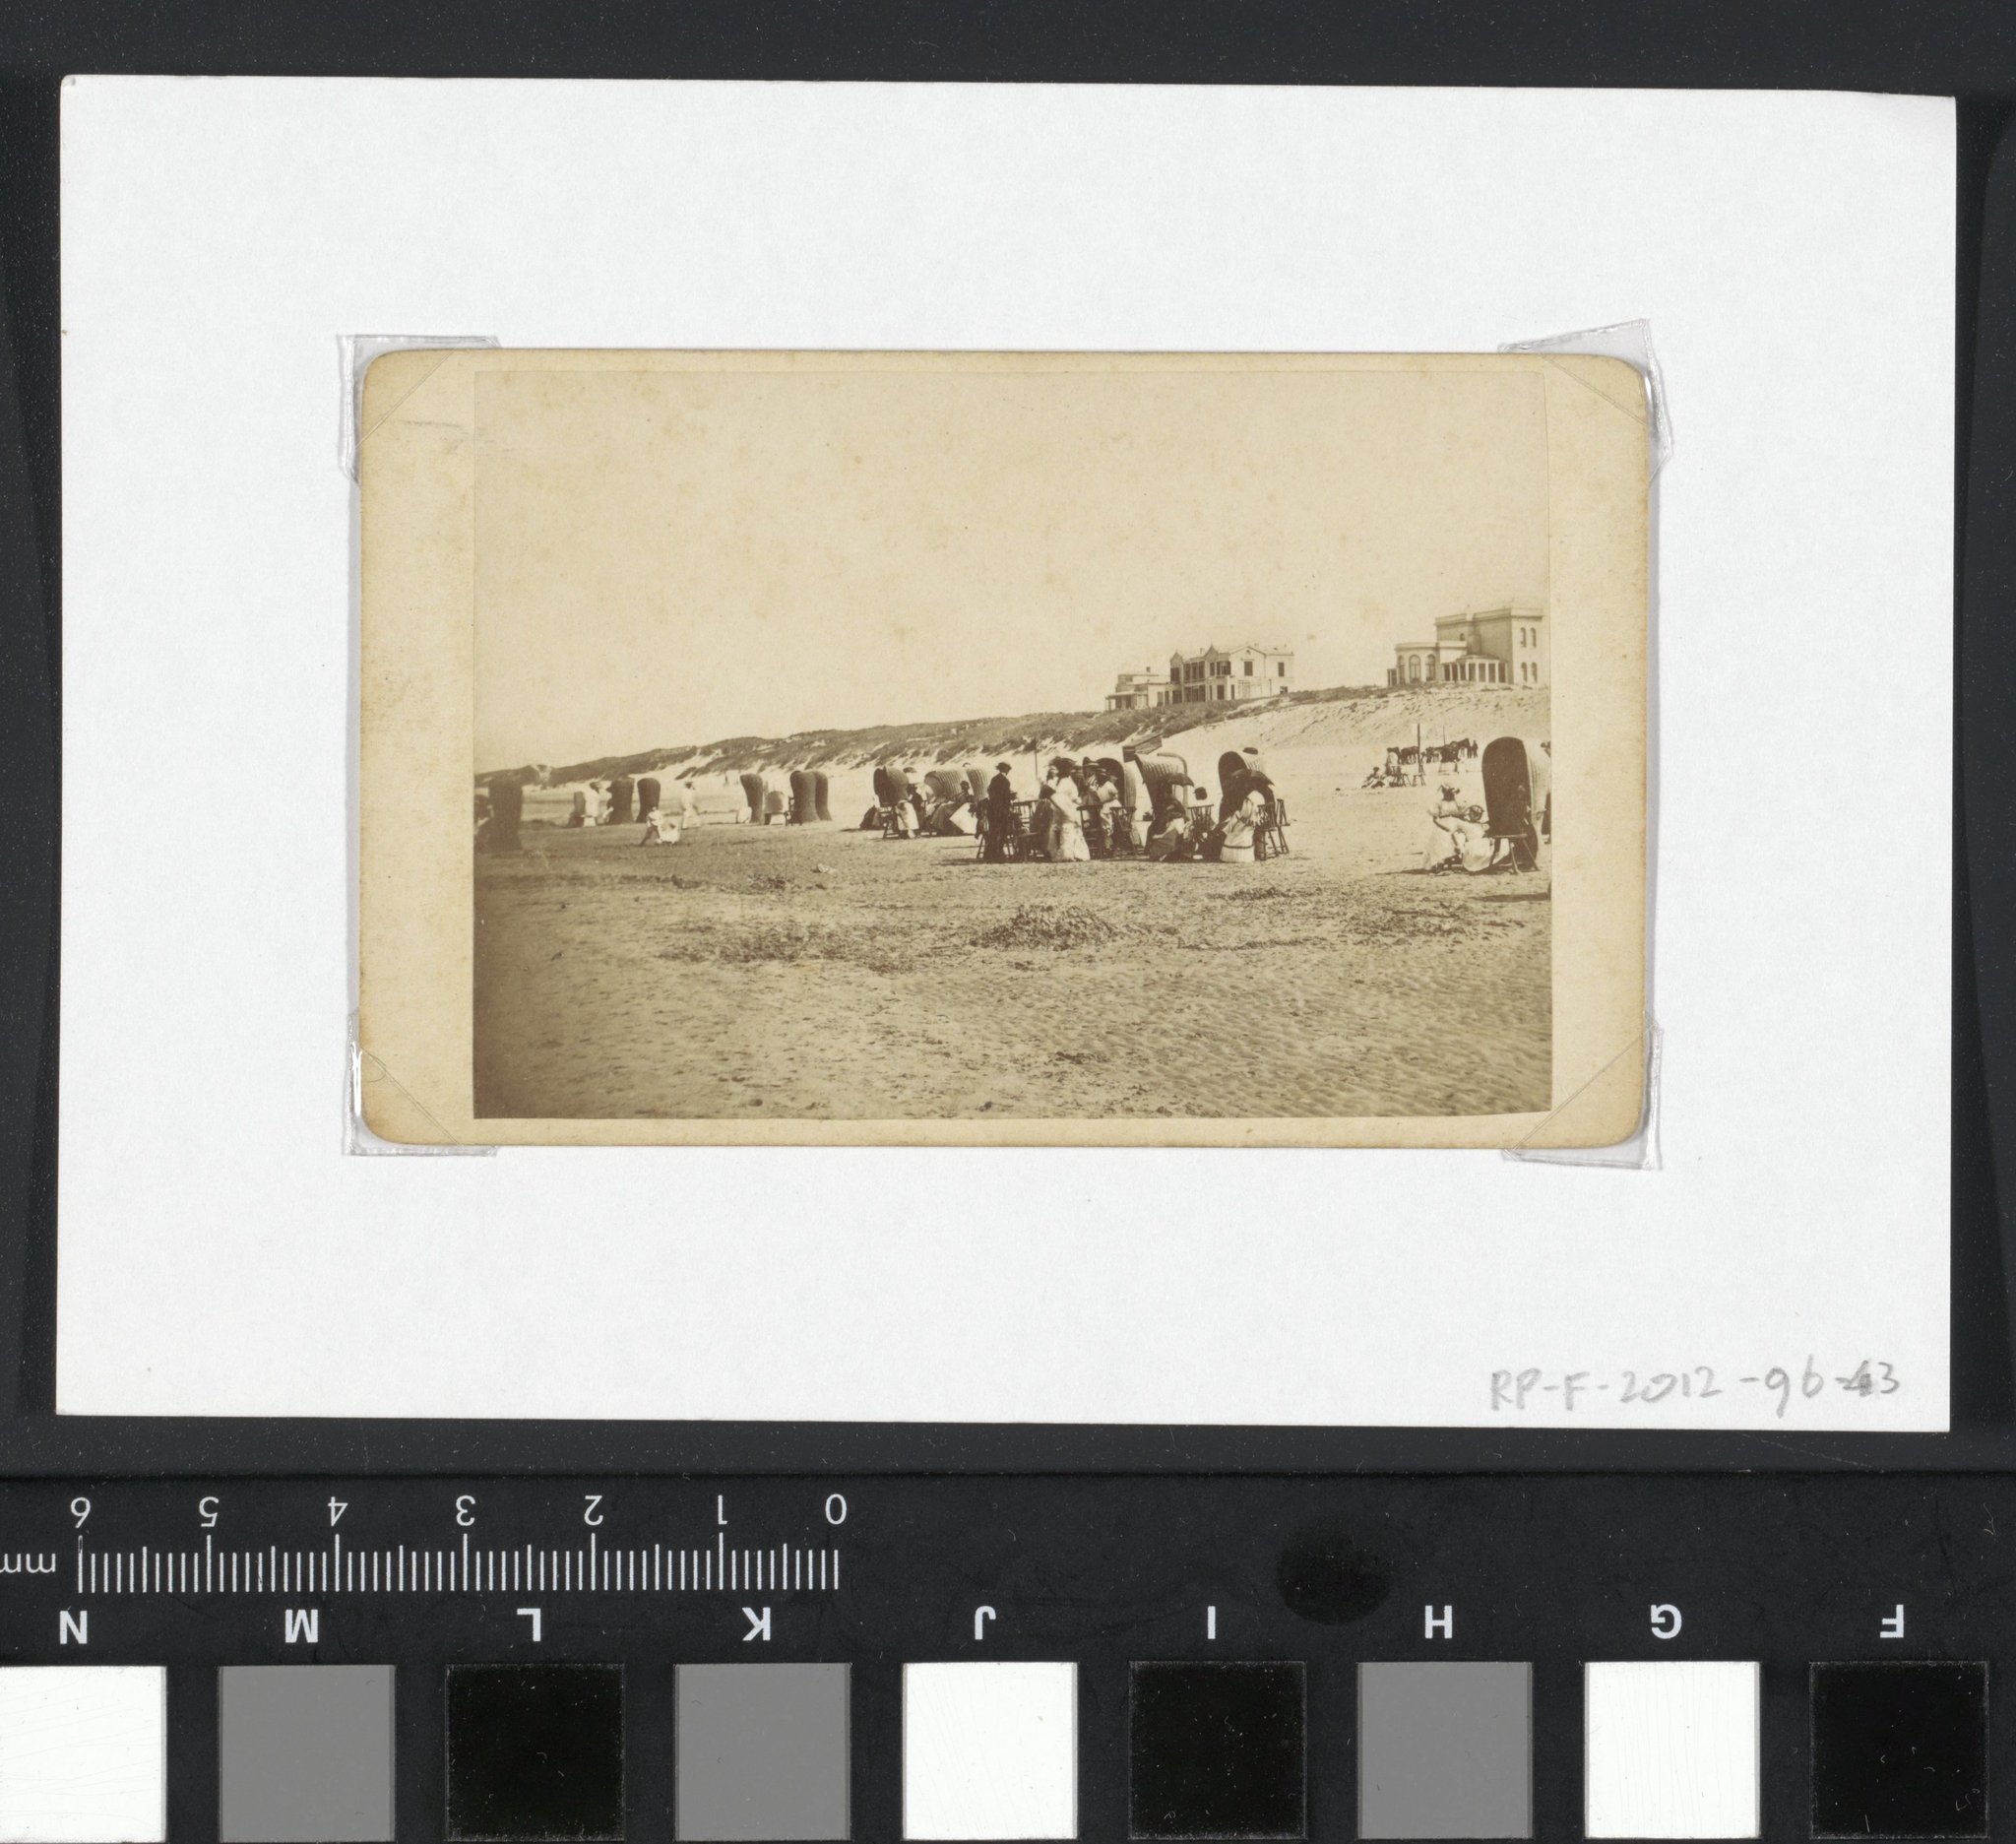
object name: photograph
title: Mensen aan het strand, vermoedelijk bij Scheveningen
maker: veuve j. van koningsveld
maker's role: fotograaf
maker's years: 1828-1907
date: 1866-1868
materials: cardboard, paper, photographic support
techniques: albumen print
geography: scheveningen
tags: beach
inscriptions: address: ‘Boterstraat Deventer en Scheveningen’